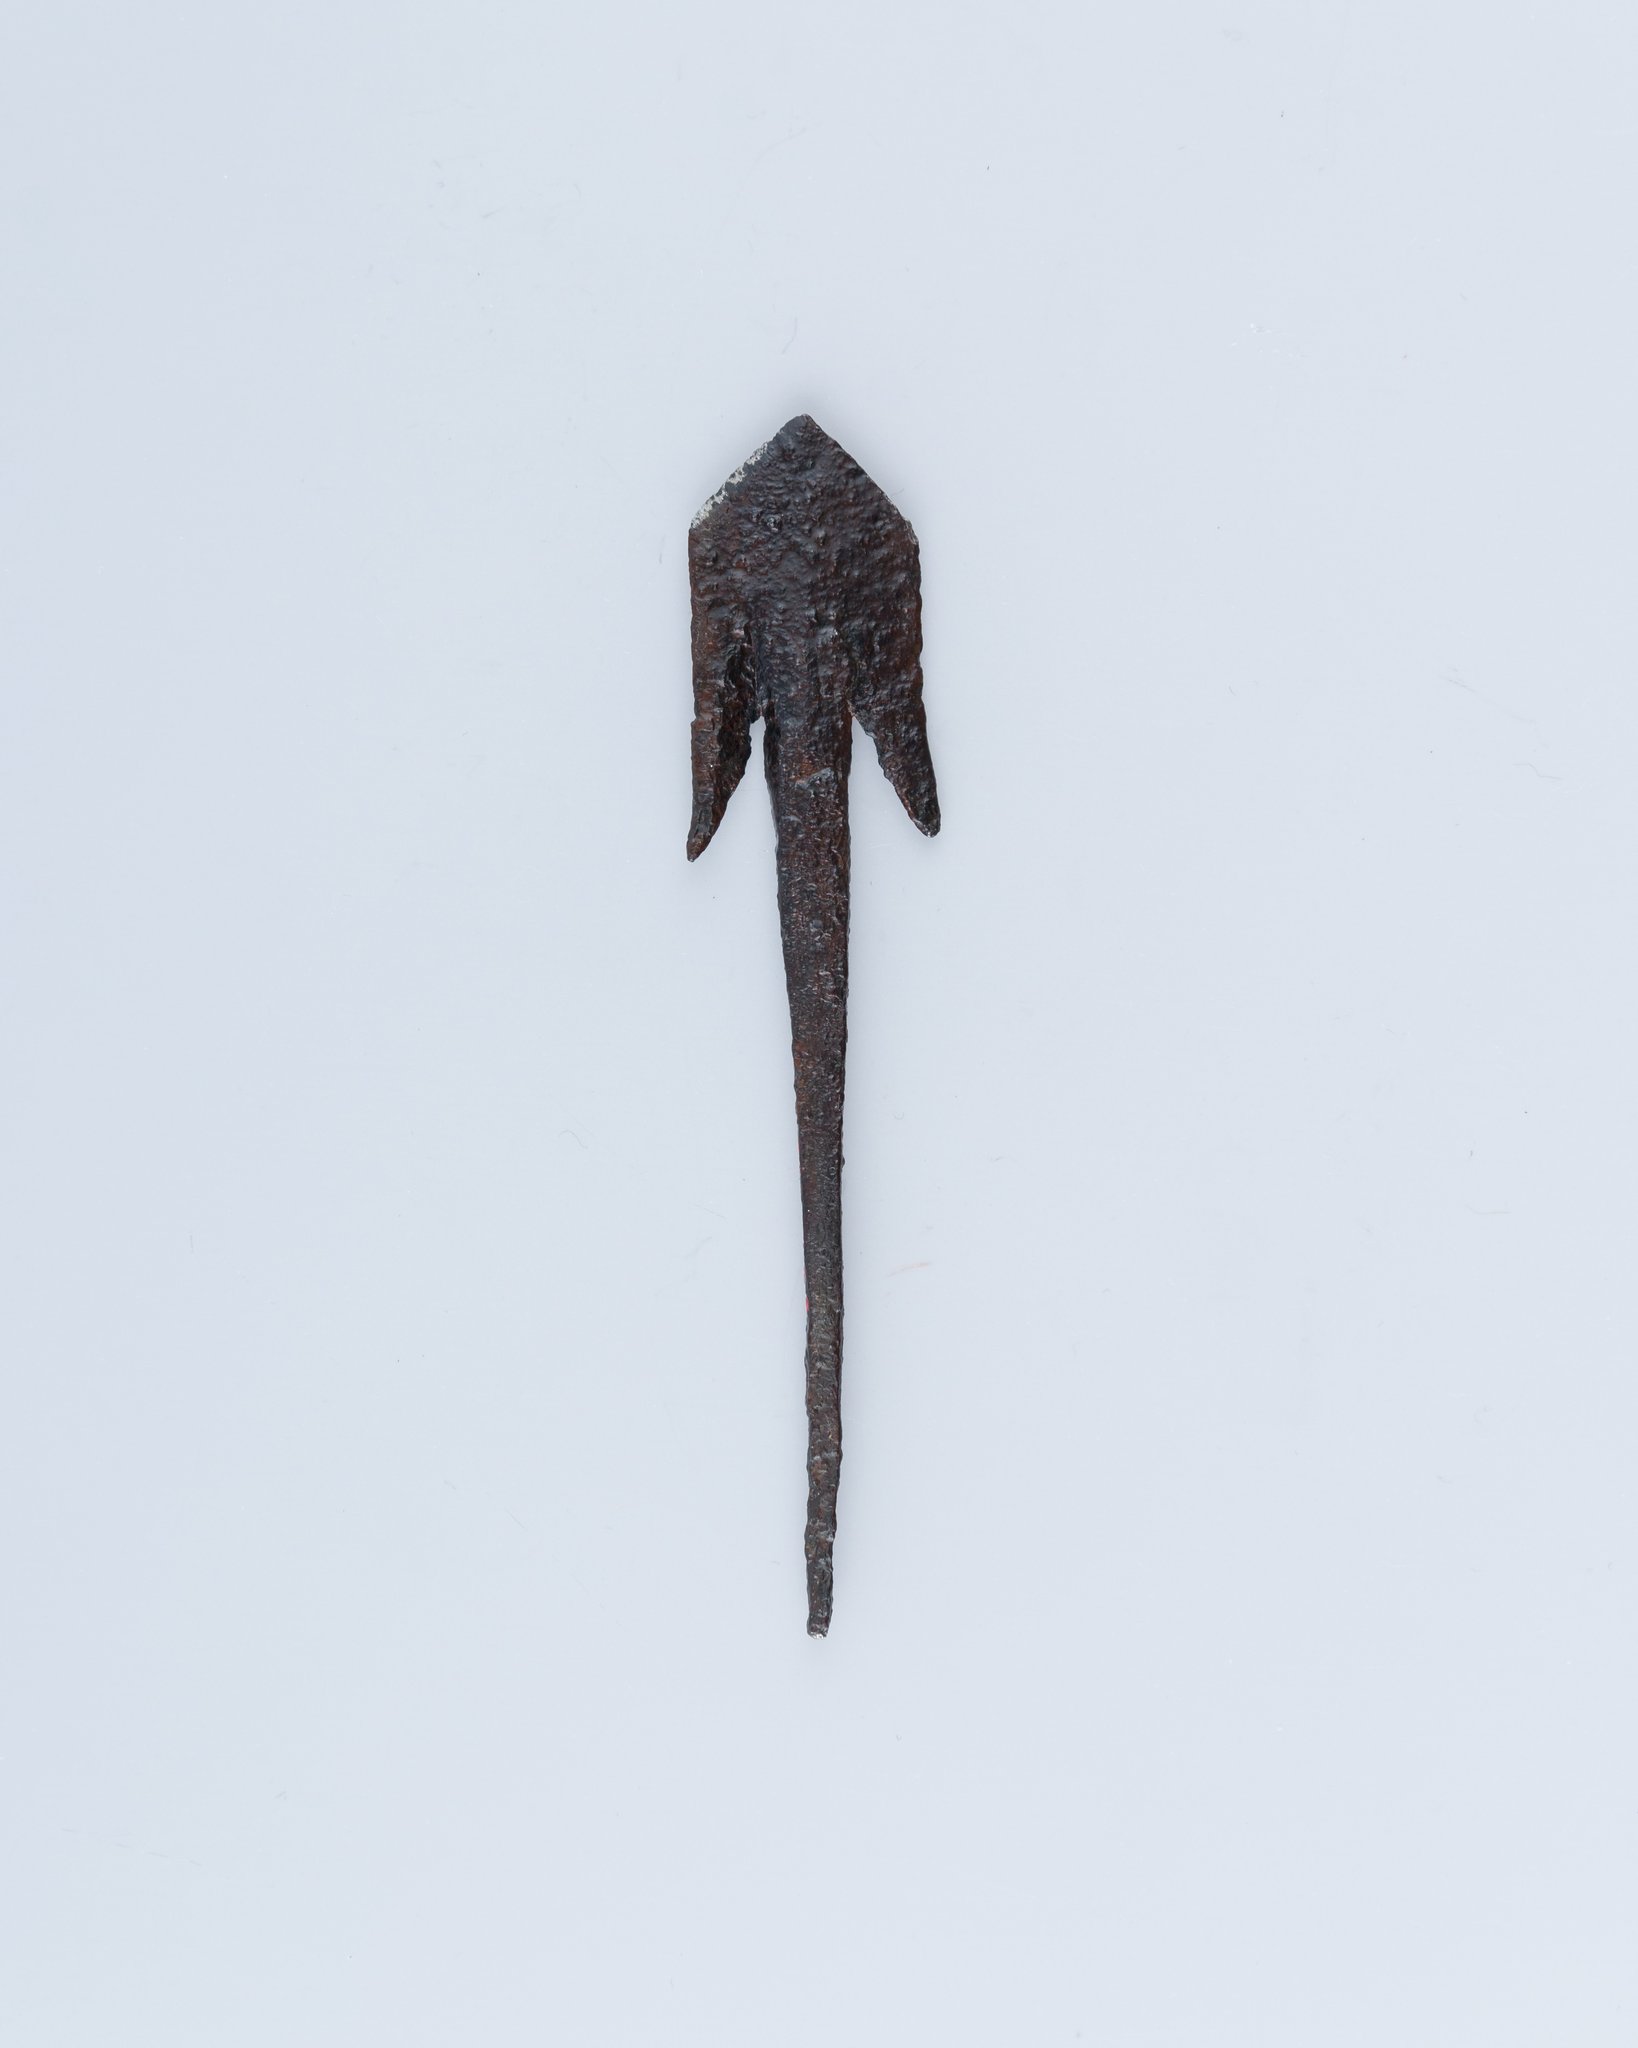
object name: arrowhead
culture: tibetan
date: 1401-1700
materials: iron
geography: tibet